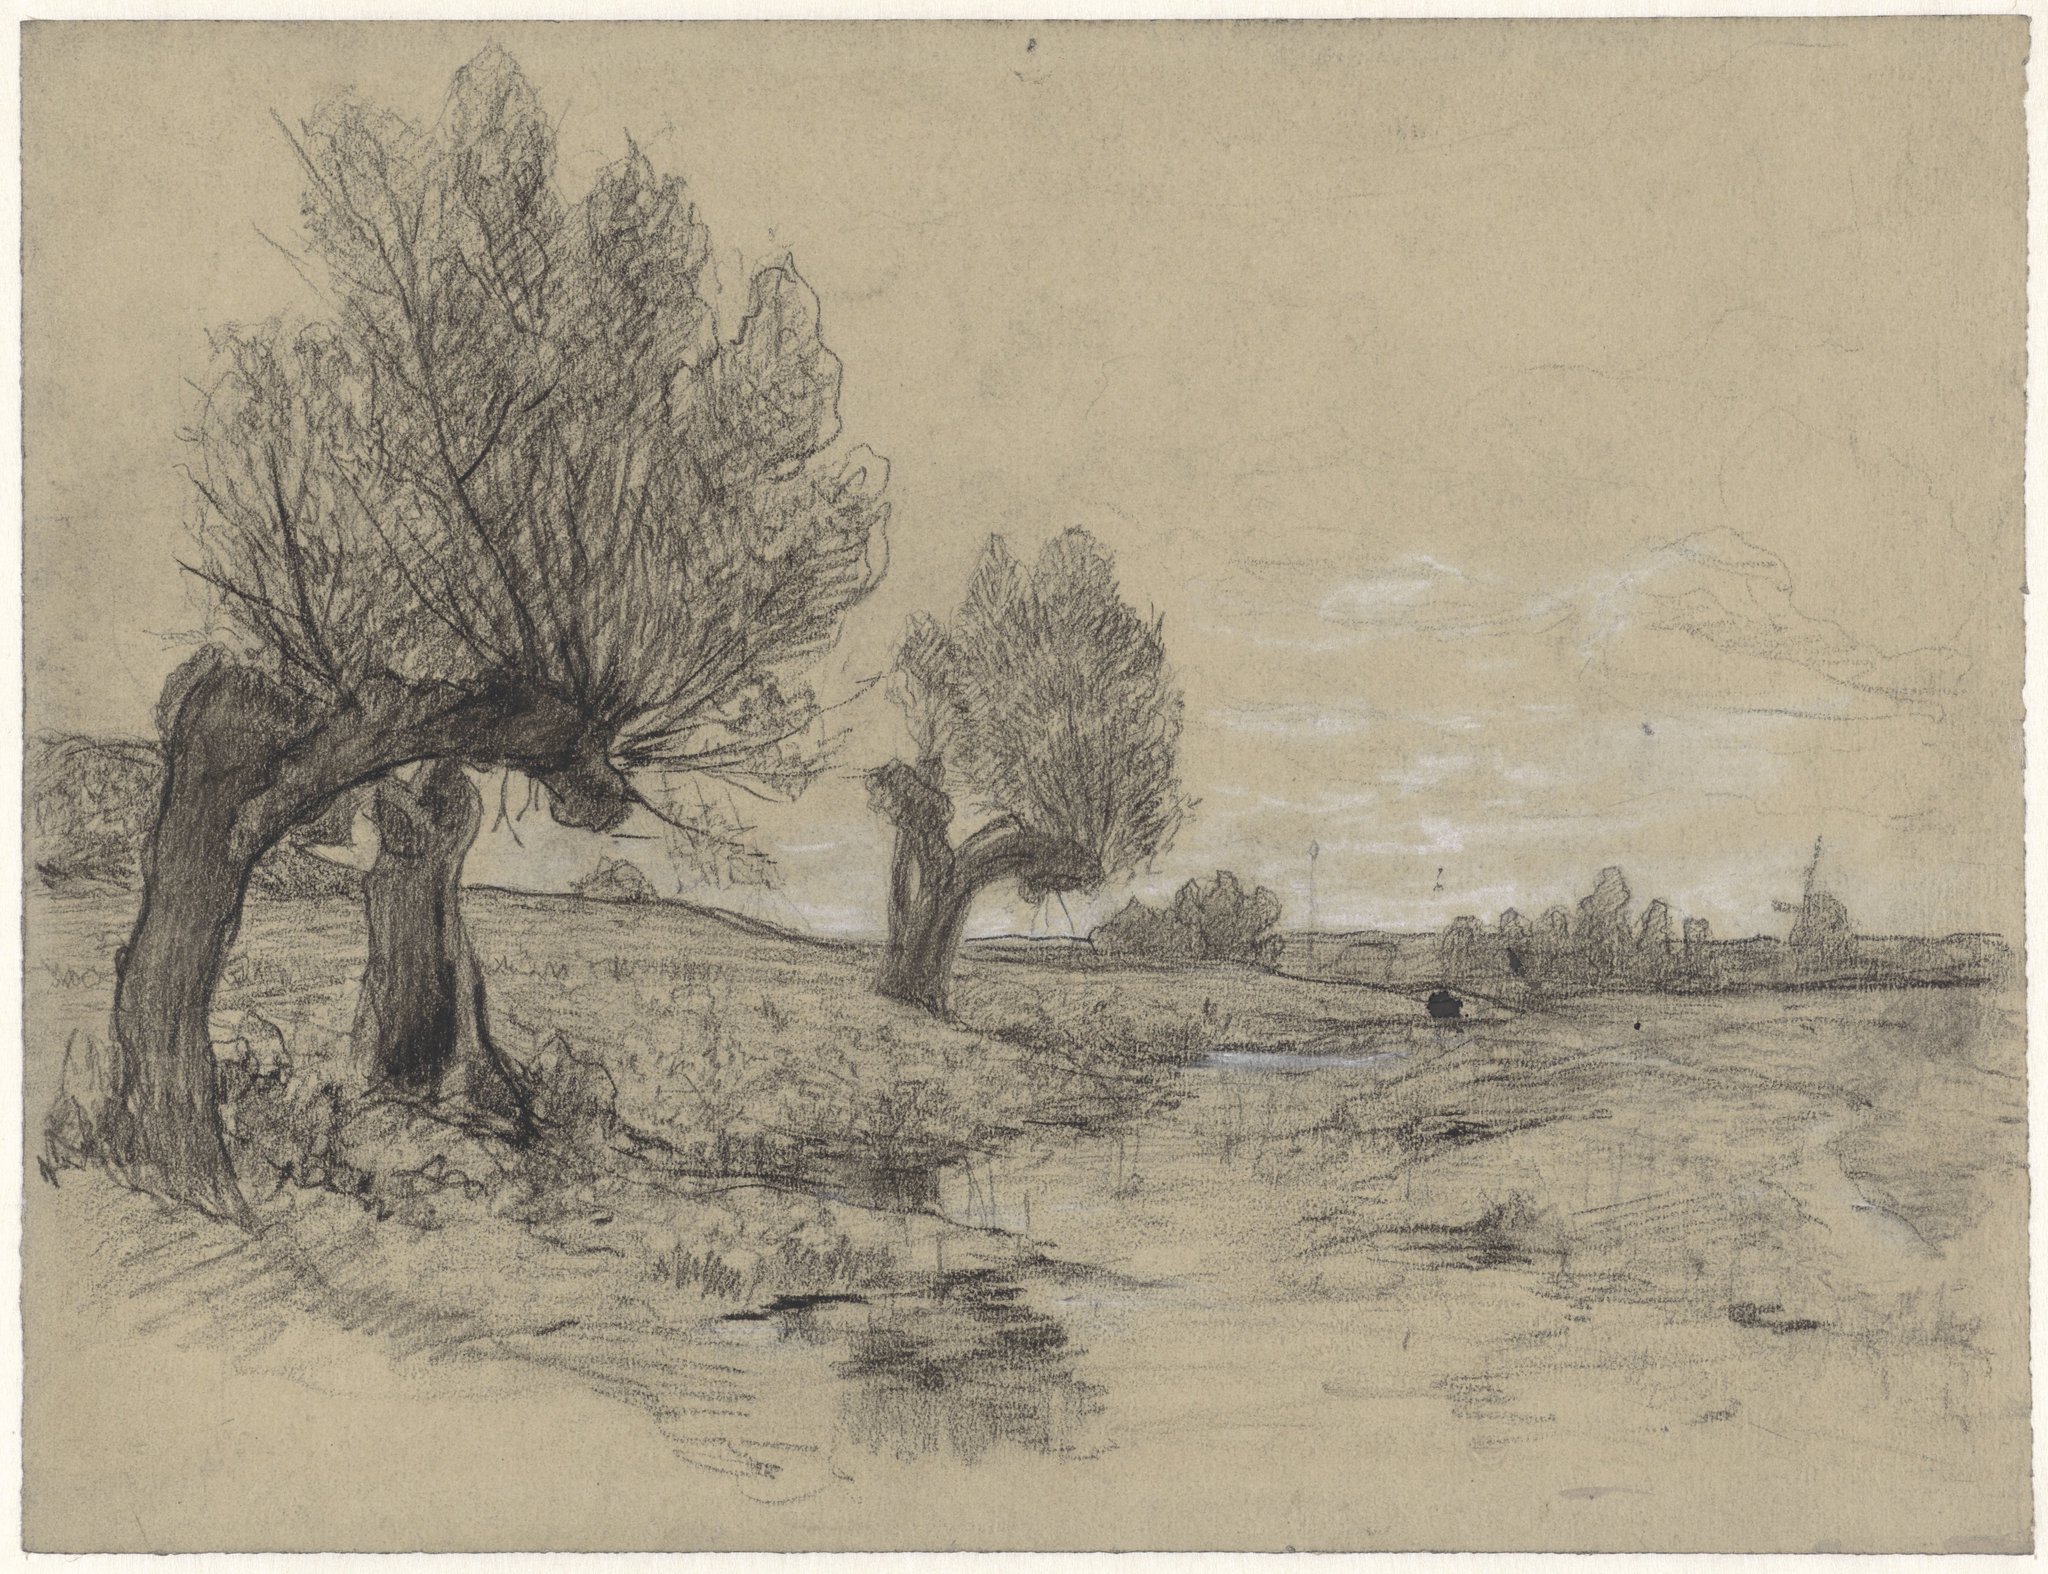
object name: drawing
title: Drie knotwilgen langs een sloot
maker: egbert rubertus derk schaap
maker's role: draughtsman, painter, print maker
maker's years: 1862-1939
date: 1872-1939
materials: chalk, paper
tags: meadow, pasture, factories and mills in landscape